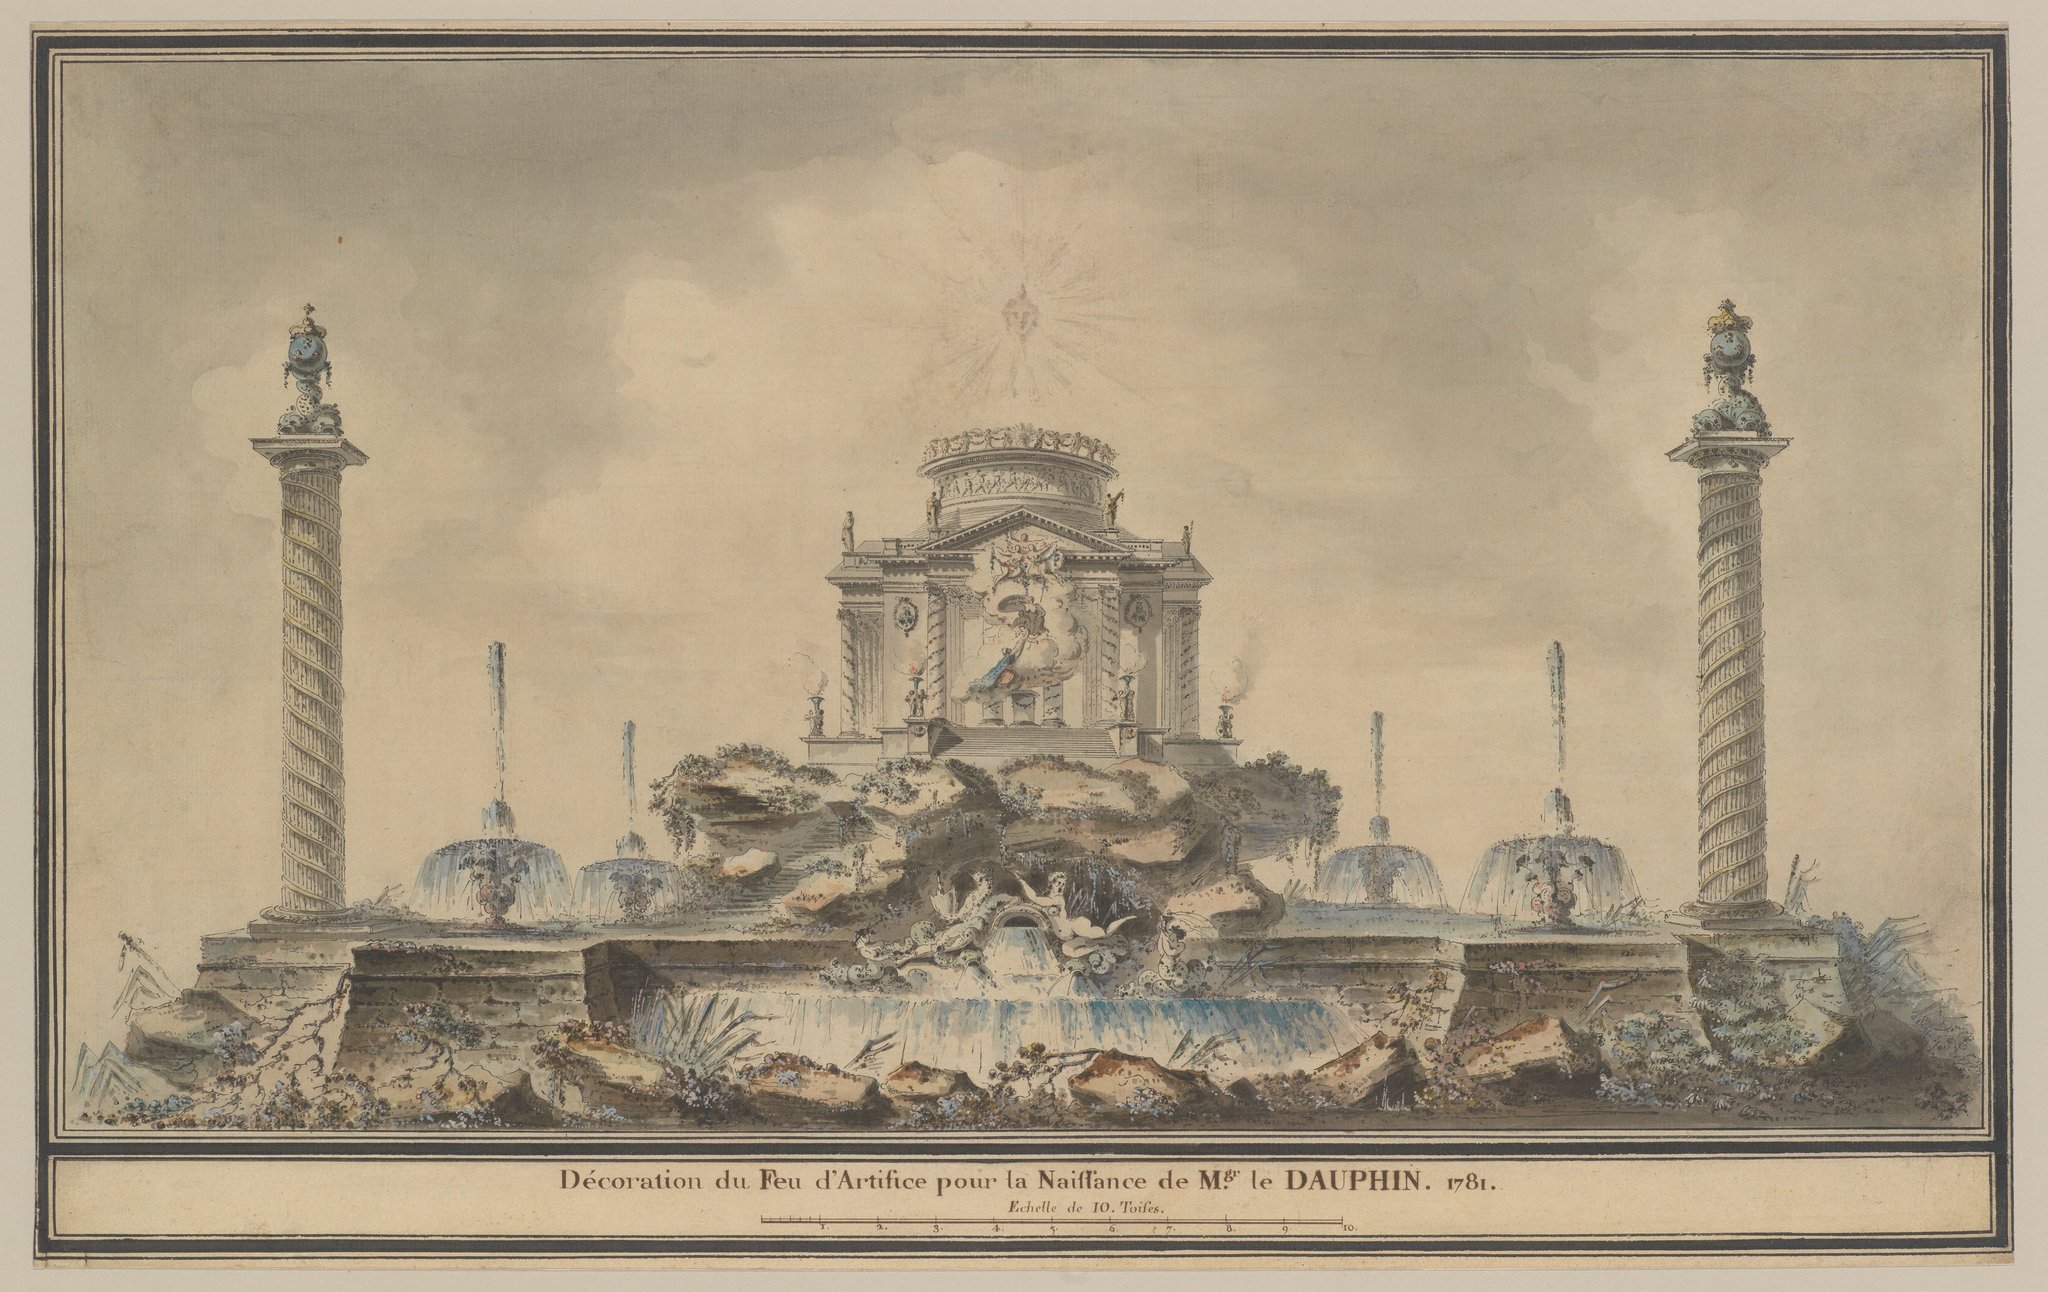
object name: drawing collection ornament architecture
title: Design for the Fireworks Display in Paris for the Birth of the Dauphin in 1781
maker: louis gustave taraval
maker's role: artist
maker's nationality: french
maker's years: 1738-1794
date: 1781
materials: gouache, ink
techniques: pen, wash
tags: fountains,fireworks